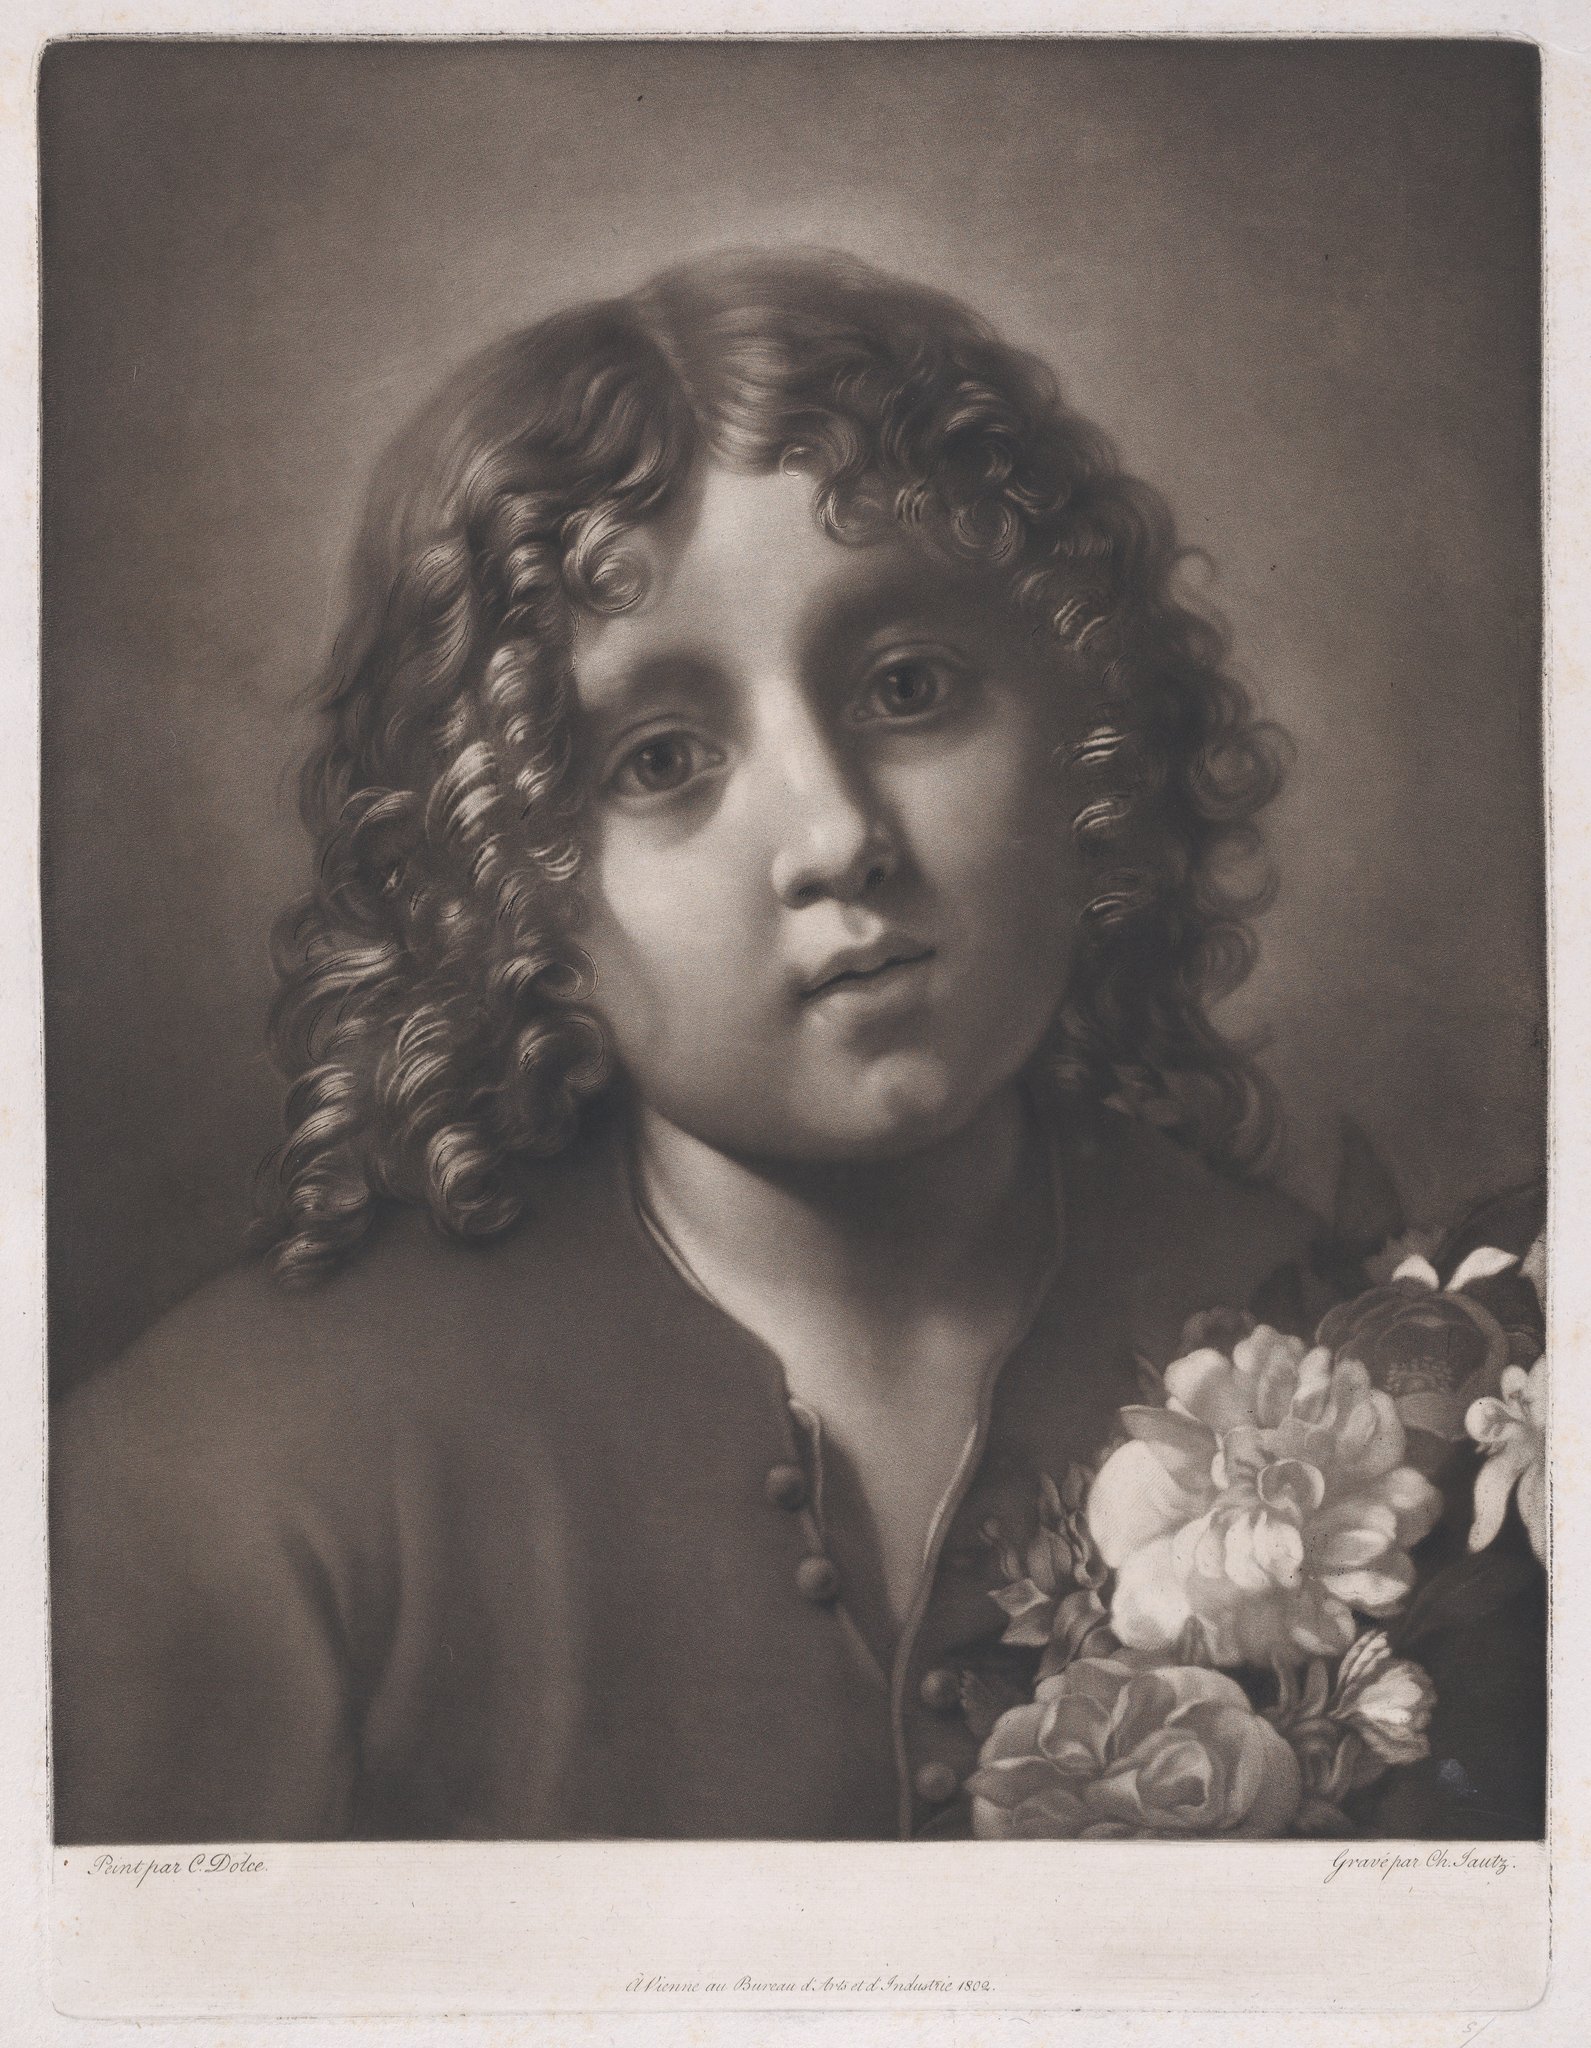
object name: print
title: Head of the young Christ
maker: karl jautz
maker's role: artist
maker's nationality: austrian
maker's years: 1780-1873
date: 1802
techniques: mezzotint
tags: christ